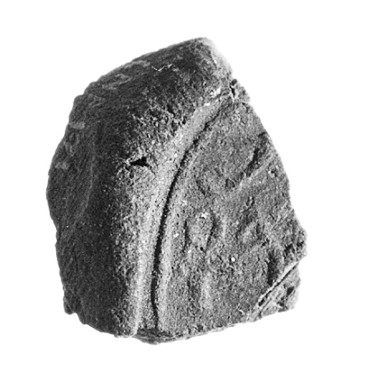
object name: sealing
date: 1981-1640 BCE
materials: mud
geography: egypt